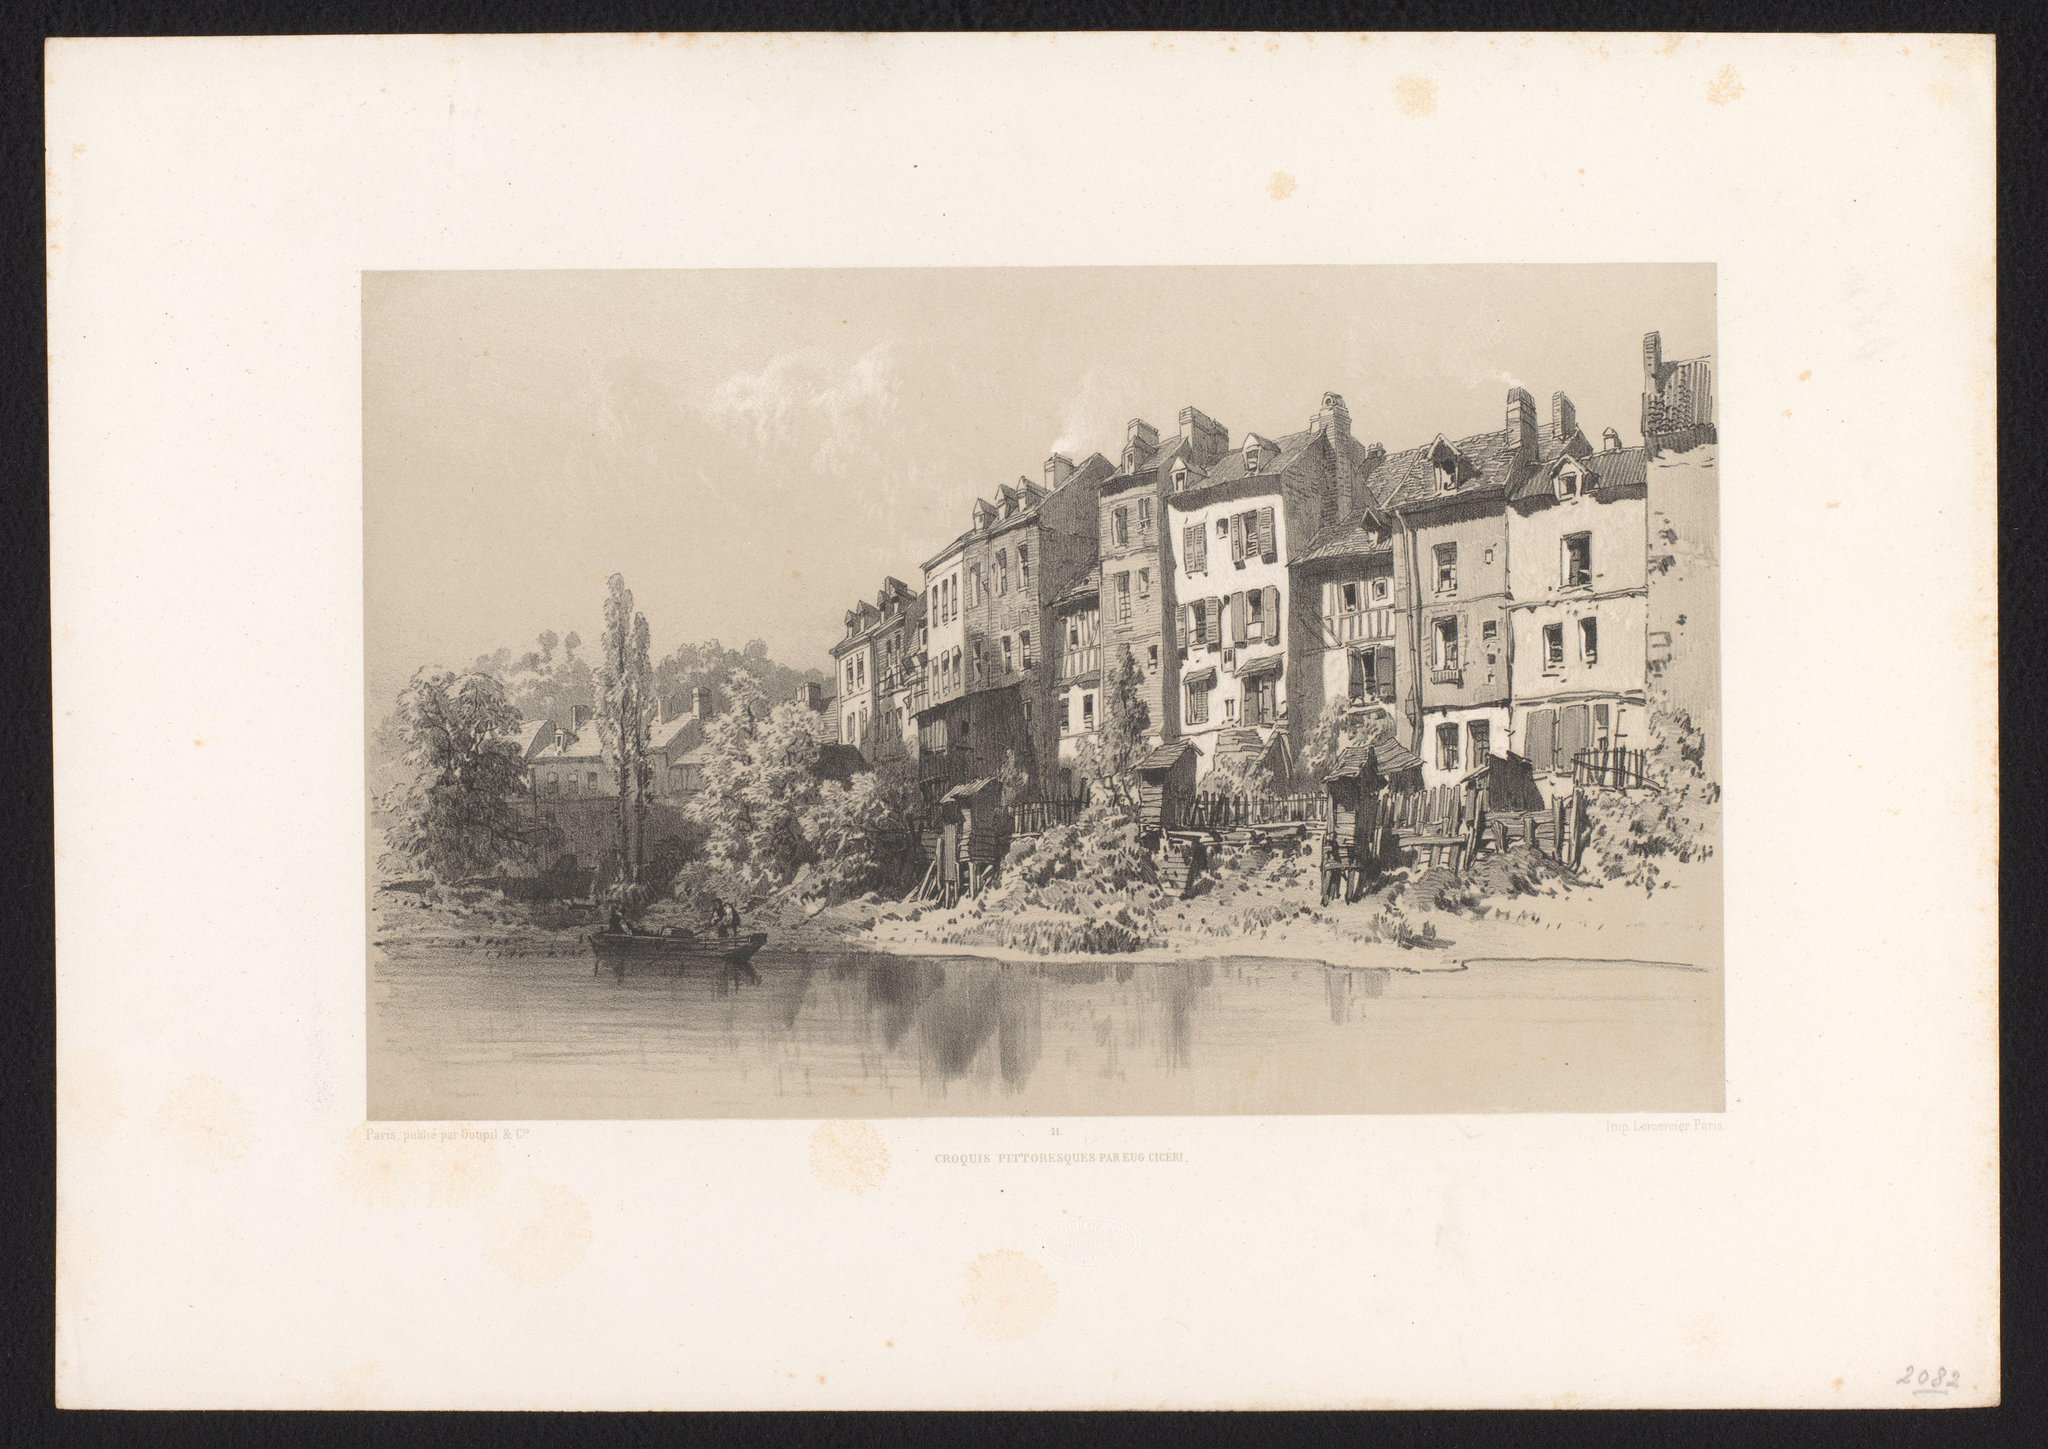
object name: print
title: Rivieroever met huizen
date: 1854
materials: paper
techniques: tone lithography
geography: paris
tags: river, rowing-boat, canoe, etc., civic architecture; edifices; dwellings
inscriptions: check stamp: Lugt 1090, number: ‘2082’